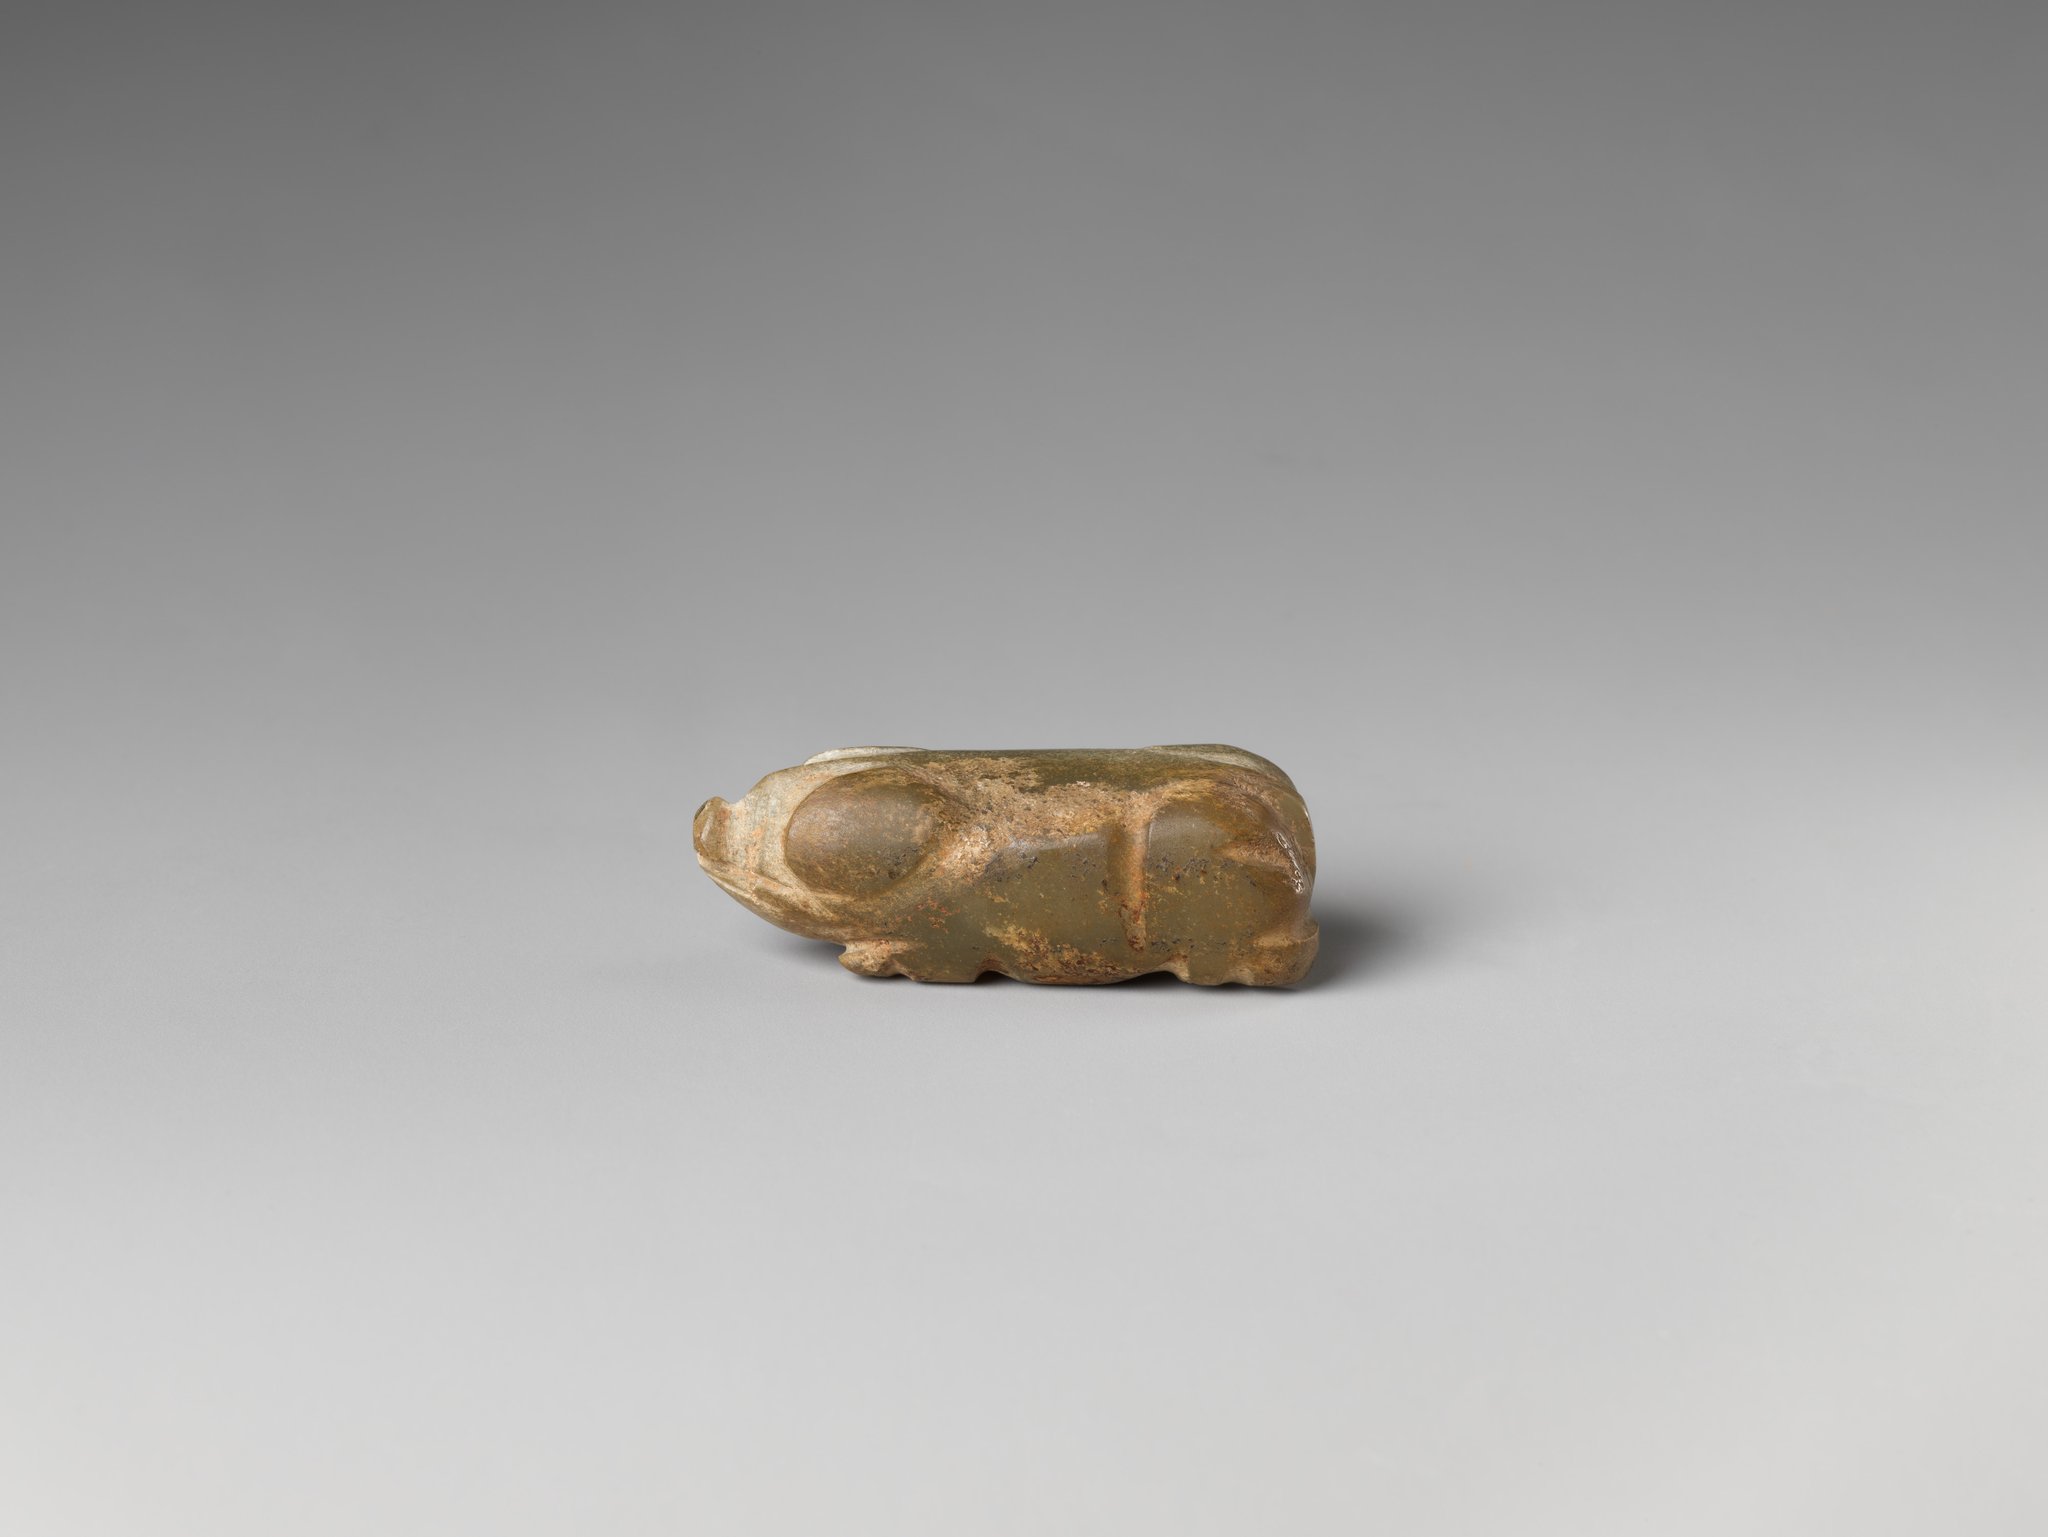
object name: figure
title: Pig in Recumbent Position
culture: chinese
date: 1-200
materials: jade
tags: pigs